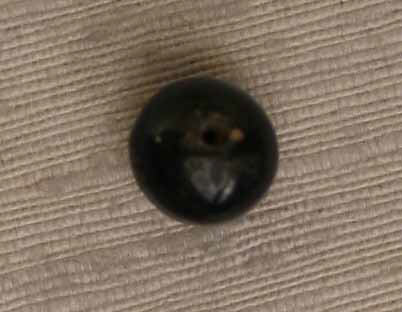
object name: bead and pendant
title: Beads and Pendants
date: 701-1300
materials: stone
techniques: cutting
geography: iran